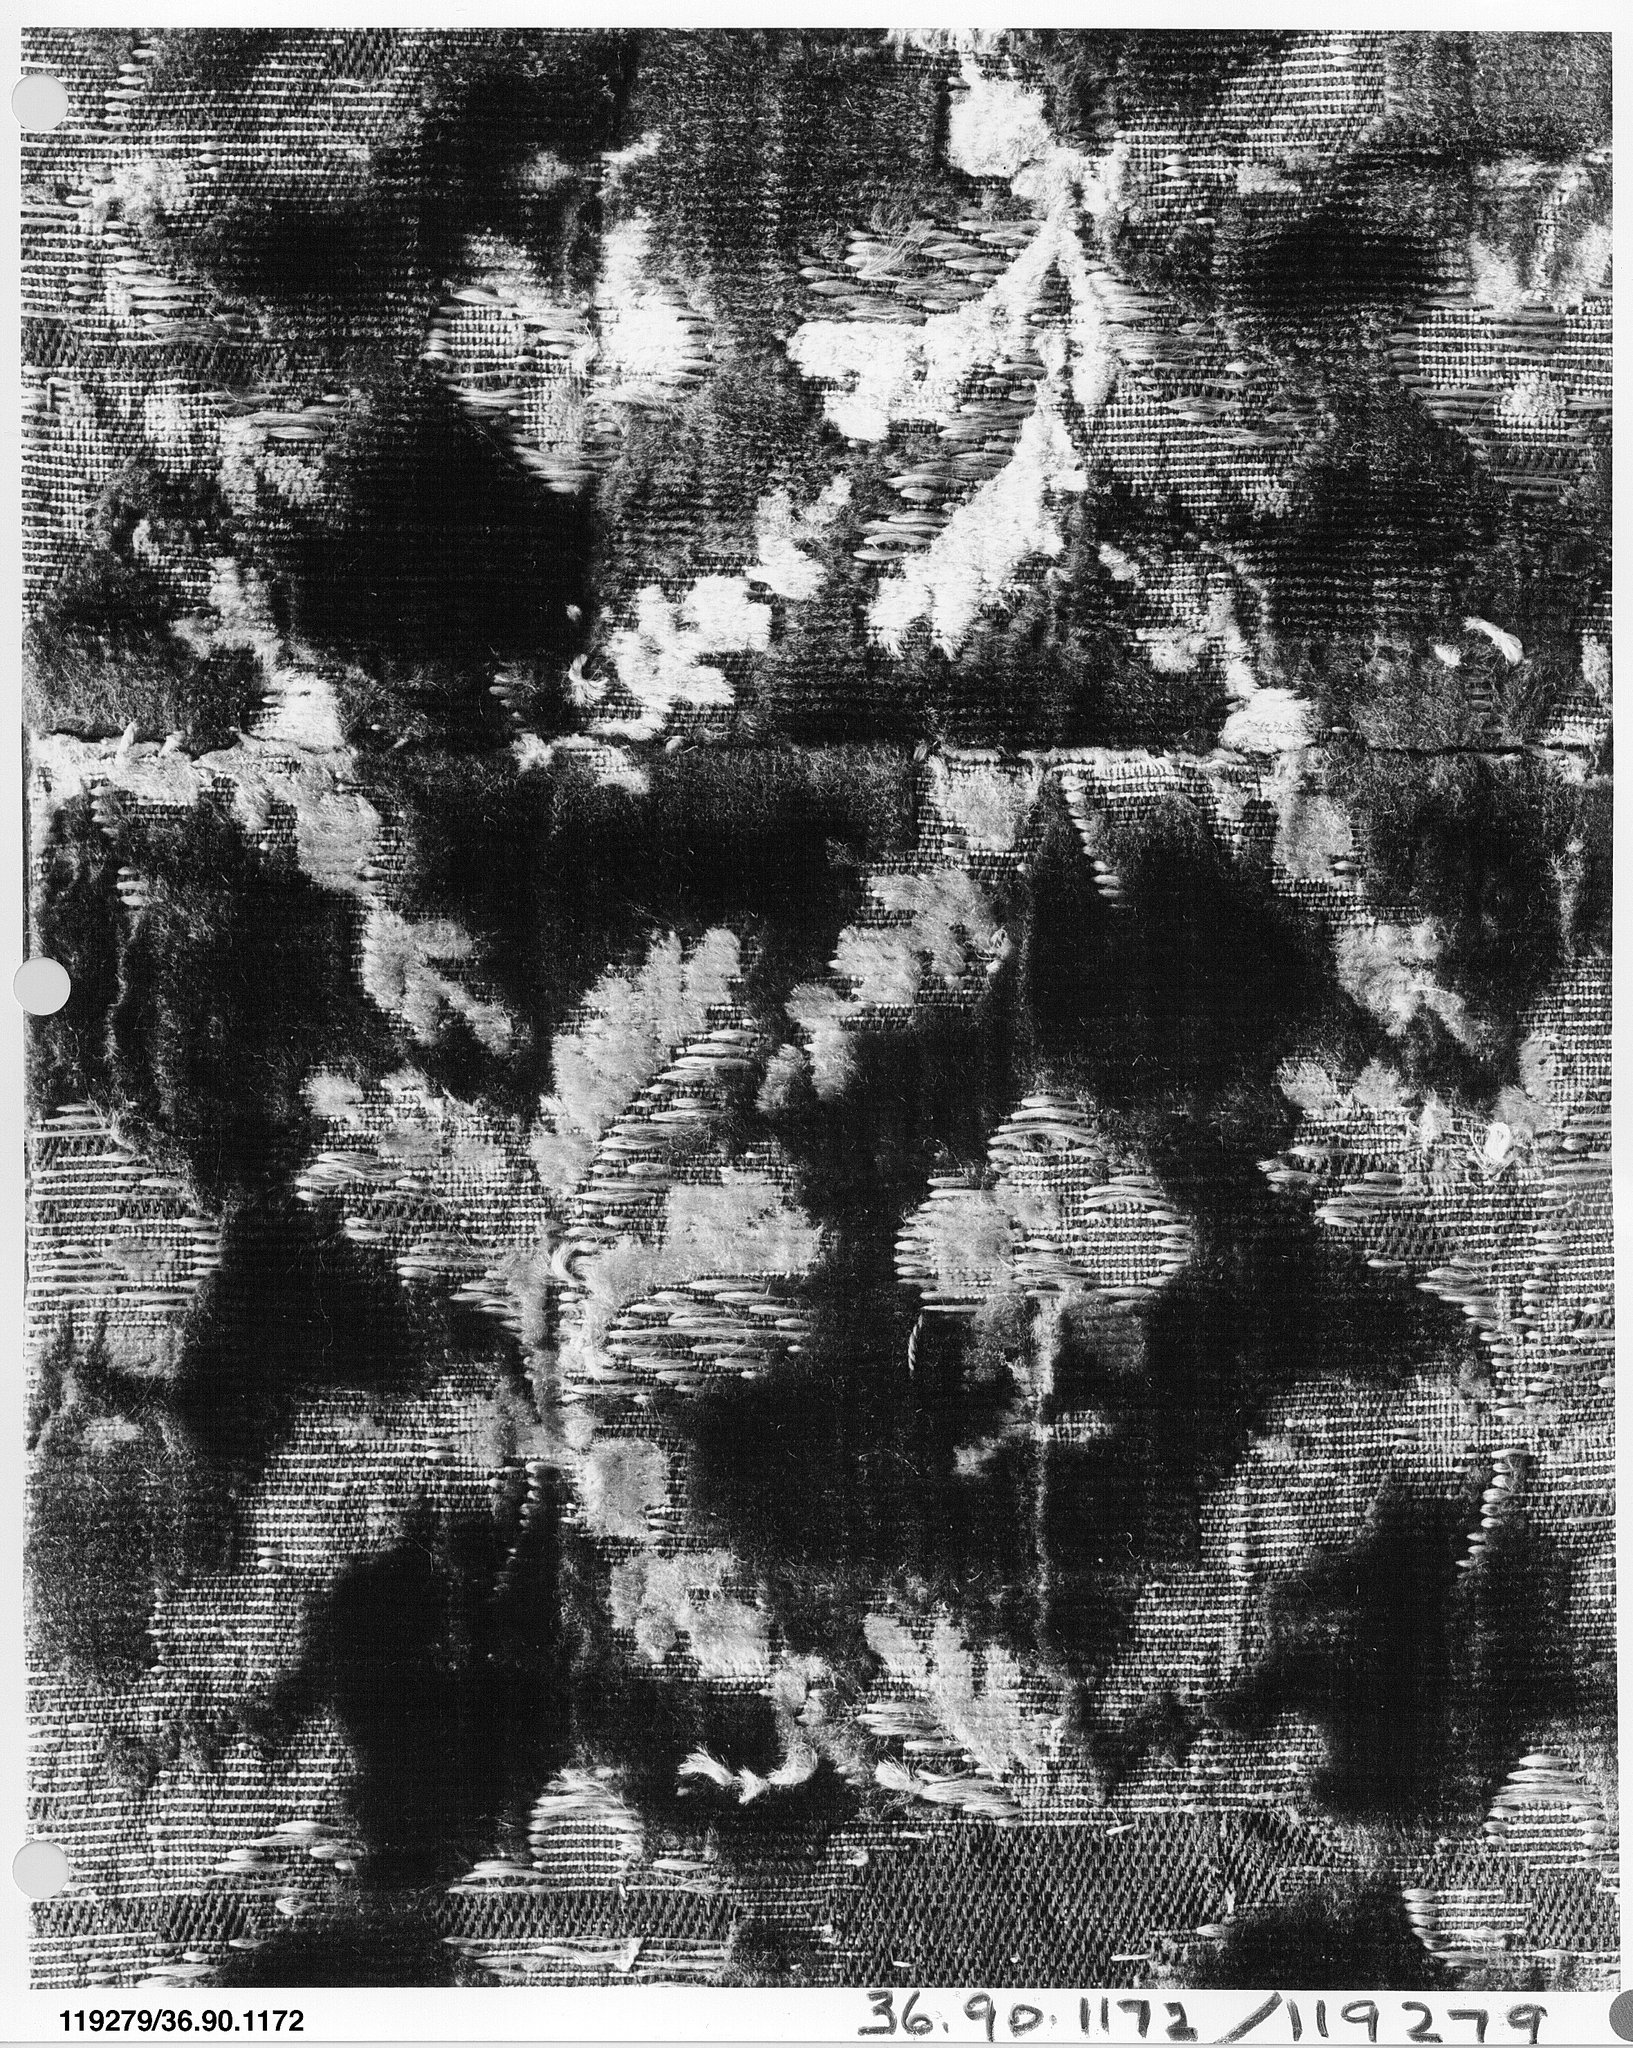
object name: piece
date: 1701-1800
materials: silk